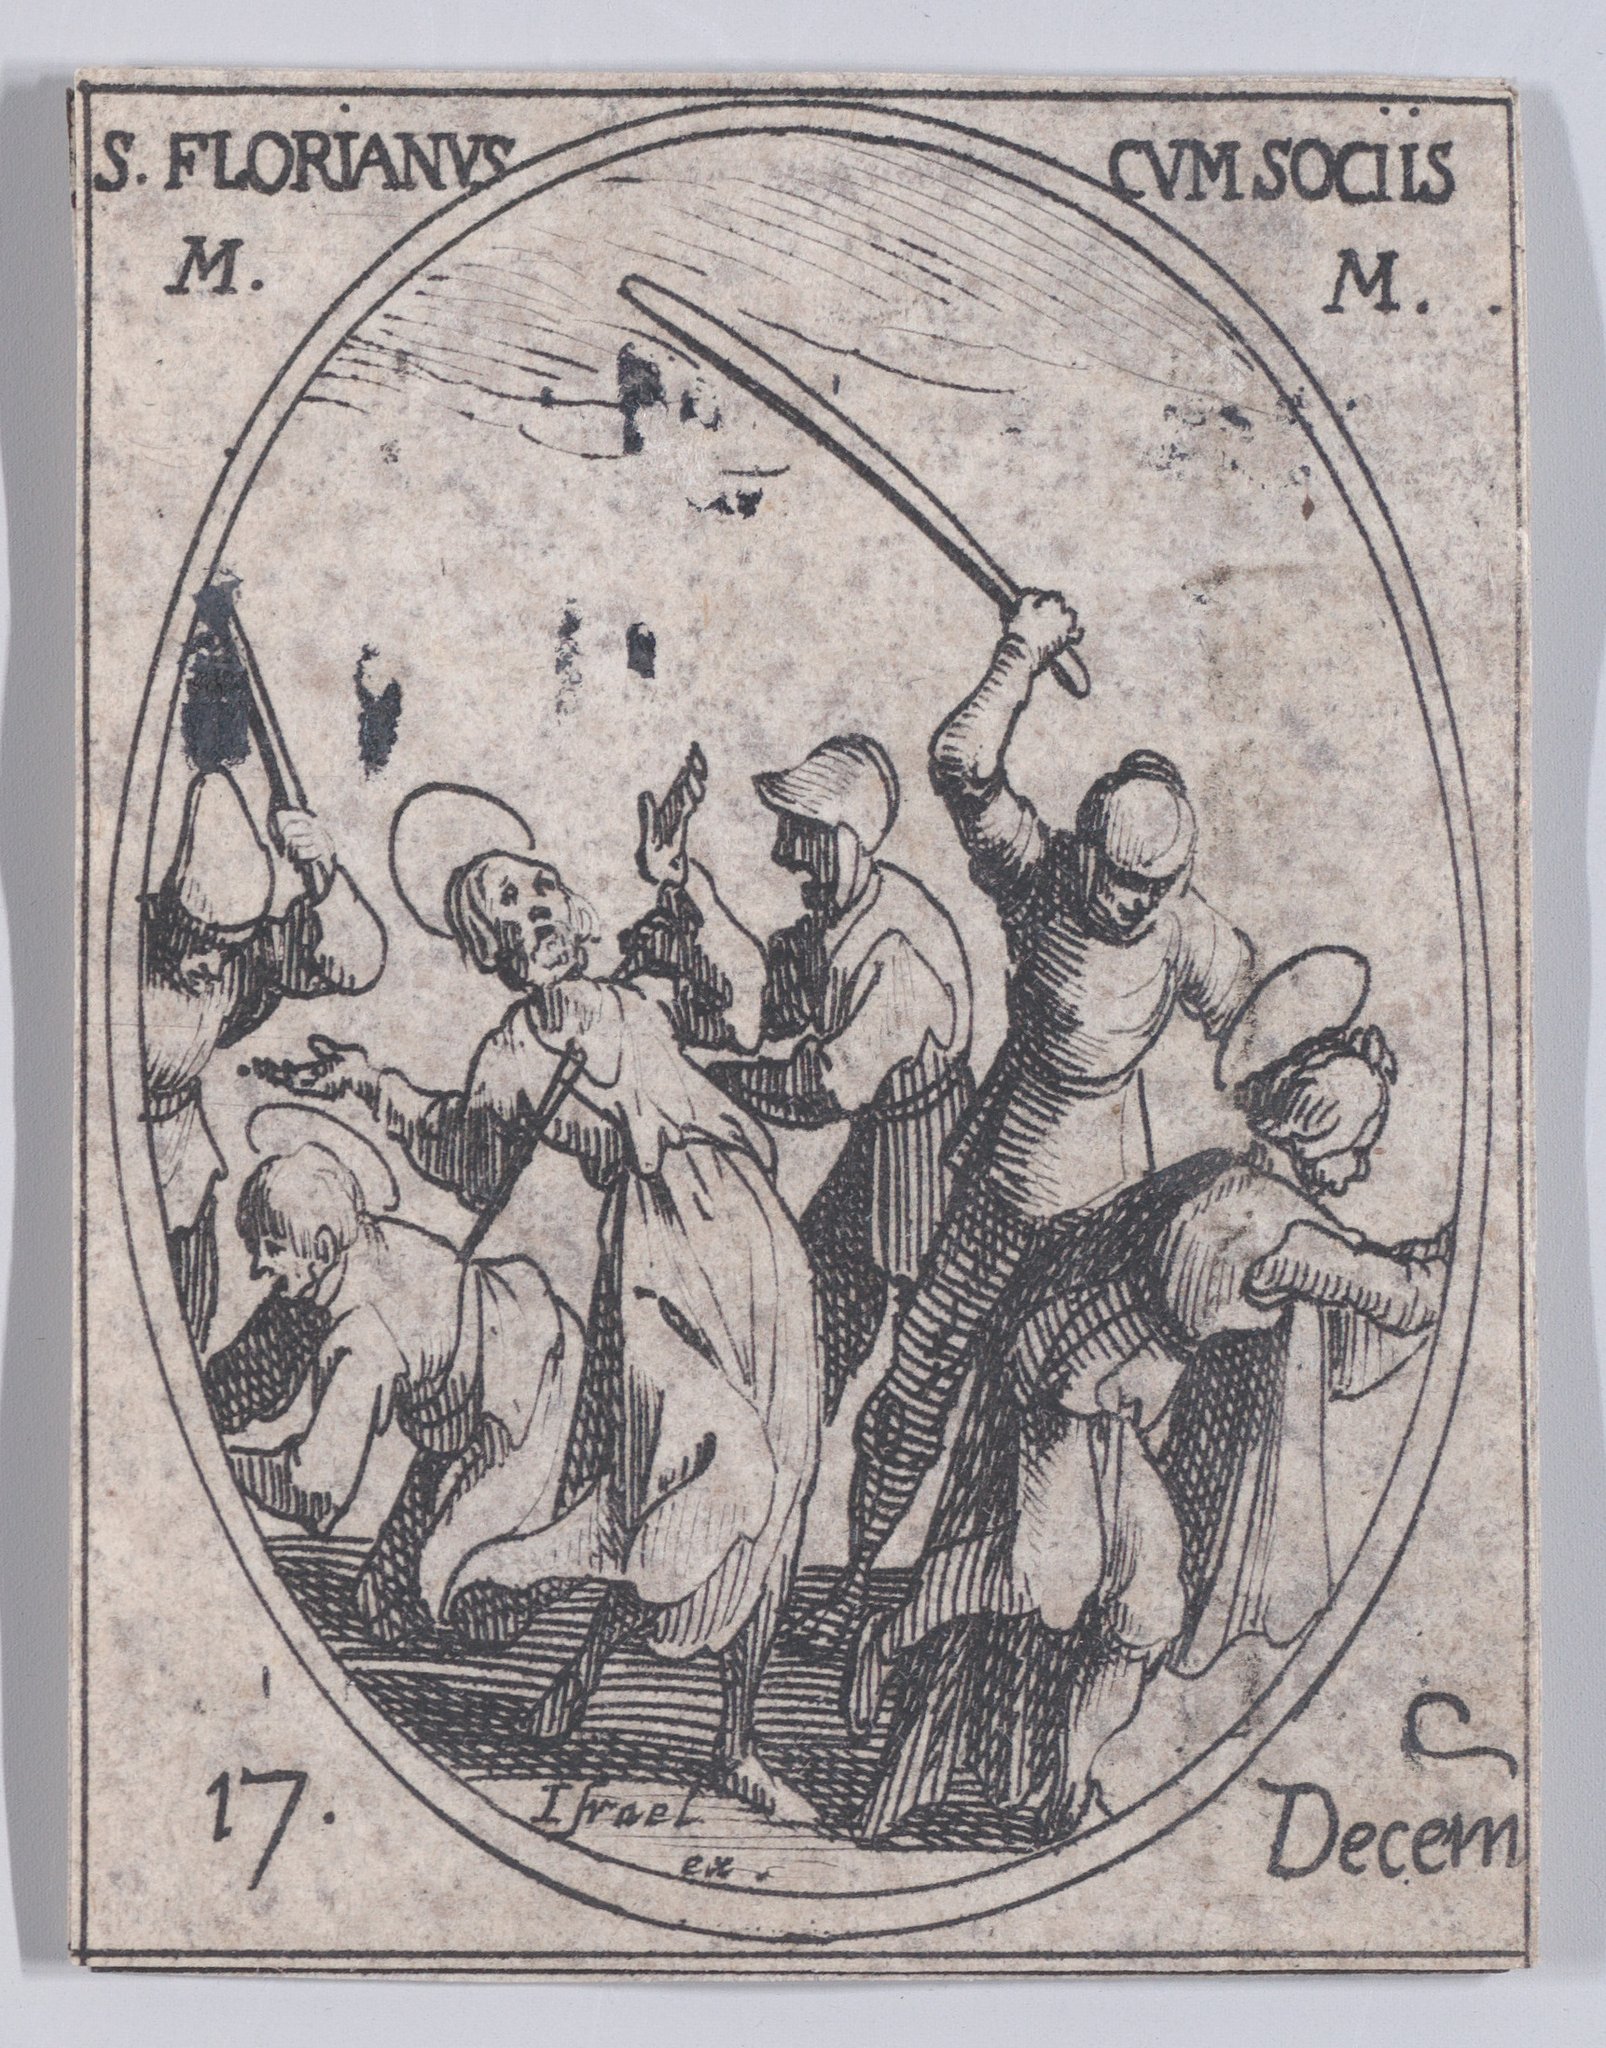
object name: print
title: S. Florien et Ses Compagnons (St. Florian and His Companions), December 17th, from "Les Images De Tous Les Saincts et Saintes de L'Année" (Images of All of the Saints and Religious Events of the Year)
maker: jacques callot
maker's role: artist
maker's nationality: french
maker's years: 1592-1635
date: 1636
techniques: etching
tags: men,saints